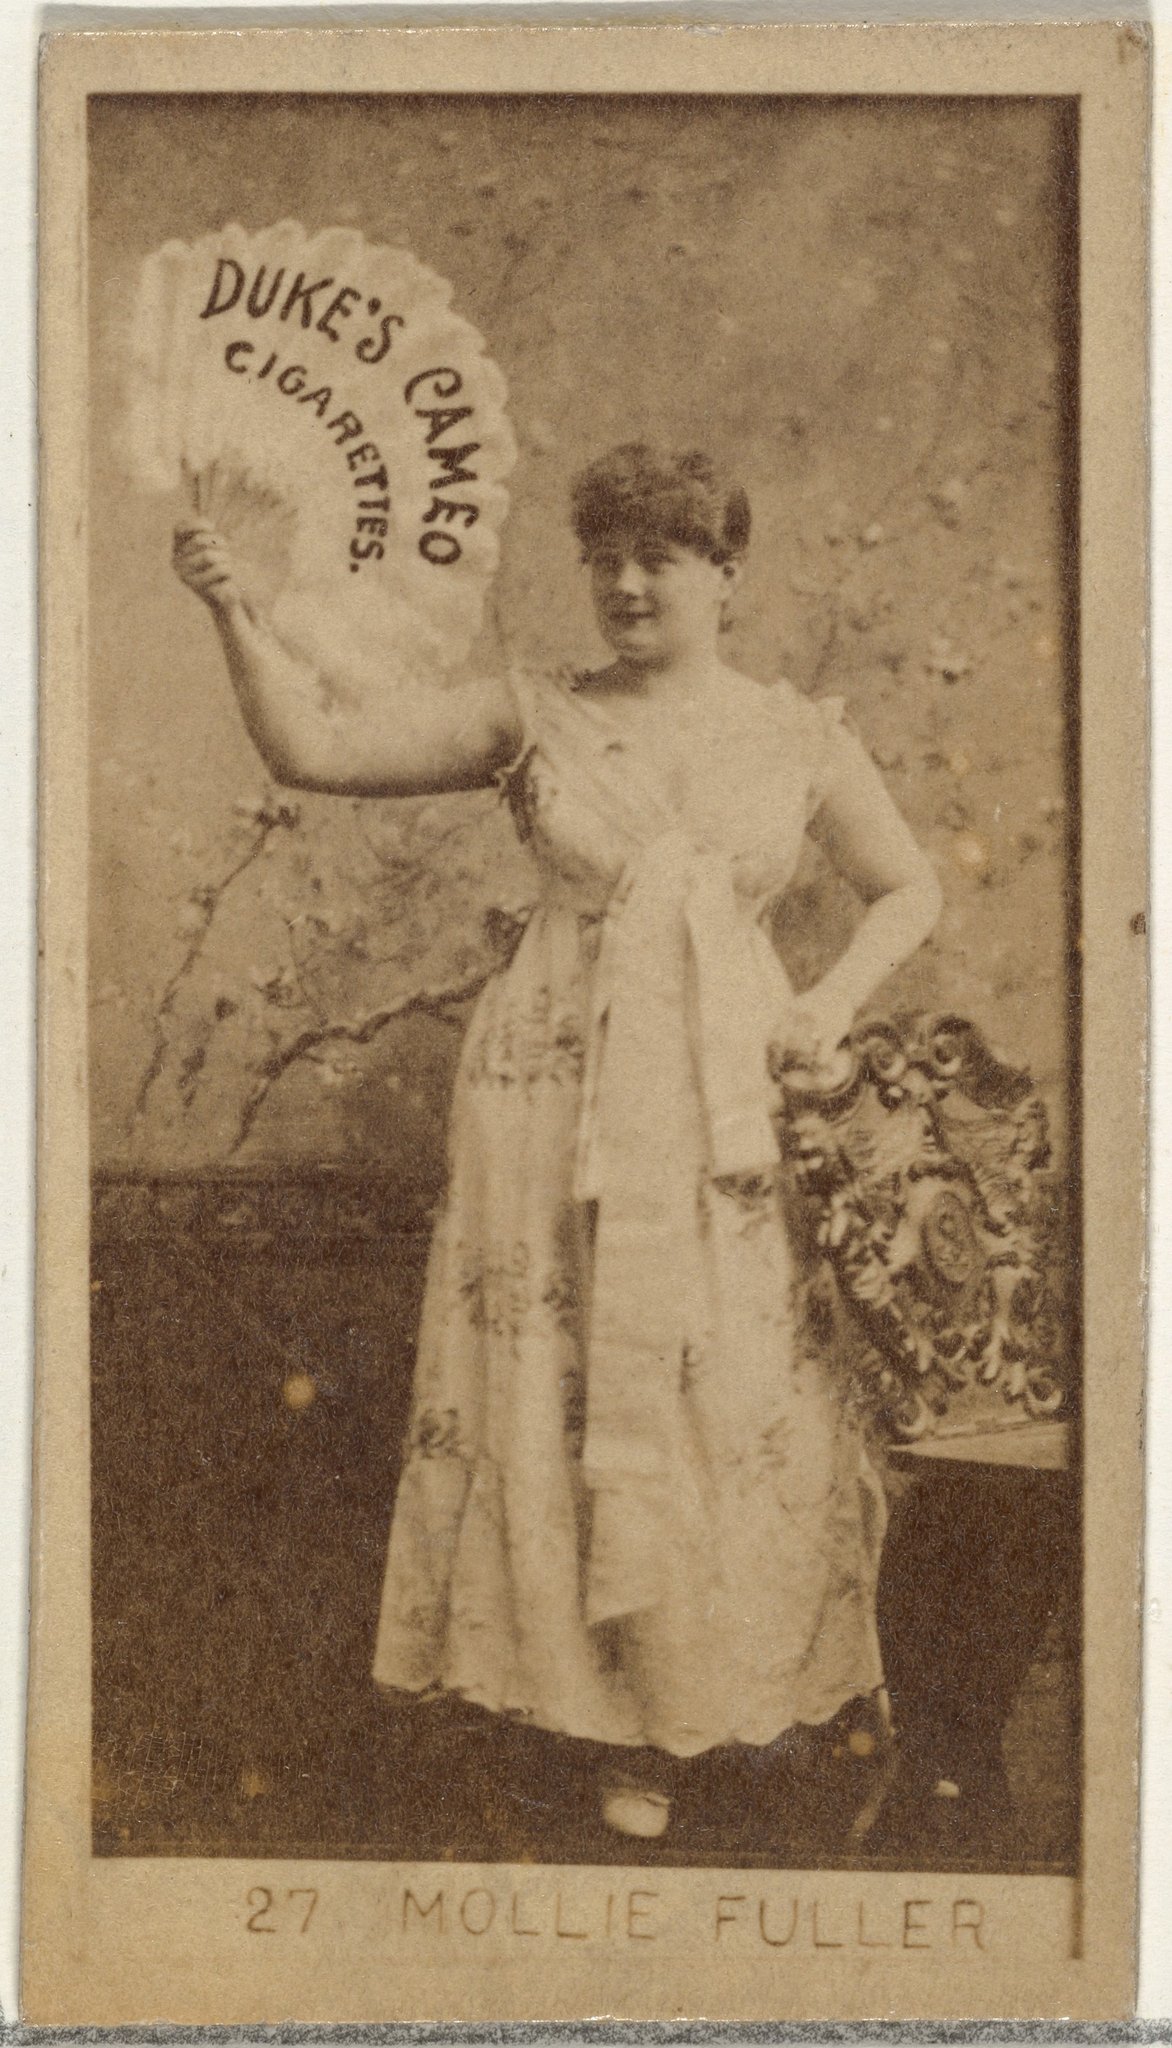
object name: photograph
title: Card Number 27, Mollie Fuller, from the Actors and Actresses series (N145-4) issued by Duke Sons & Co. to promote Cameo Cigarettes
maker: w. duke, sons & co.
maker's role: publisher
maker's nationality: american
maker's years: 1870-1920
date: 1880-1889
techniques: albumen silver print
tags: portraits,women,actresses